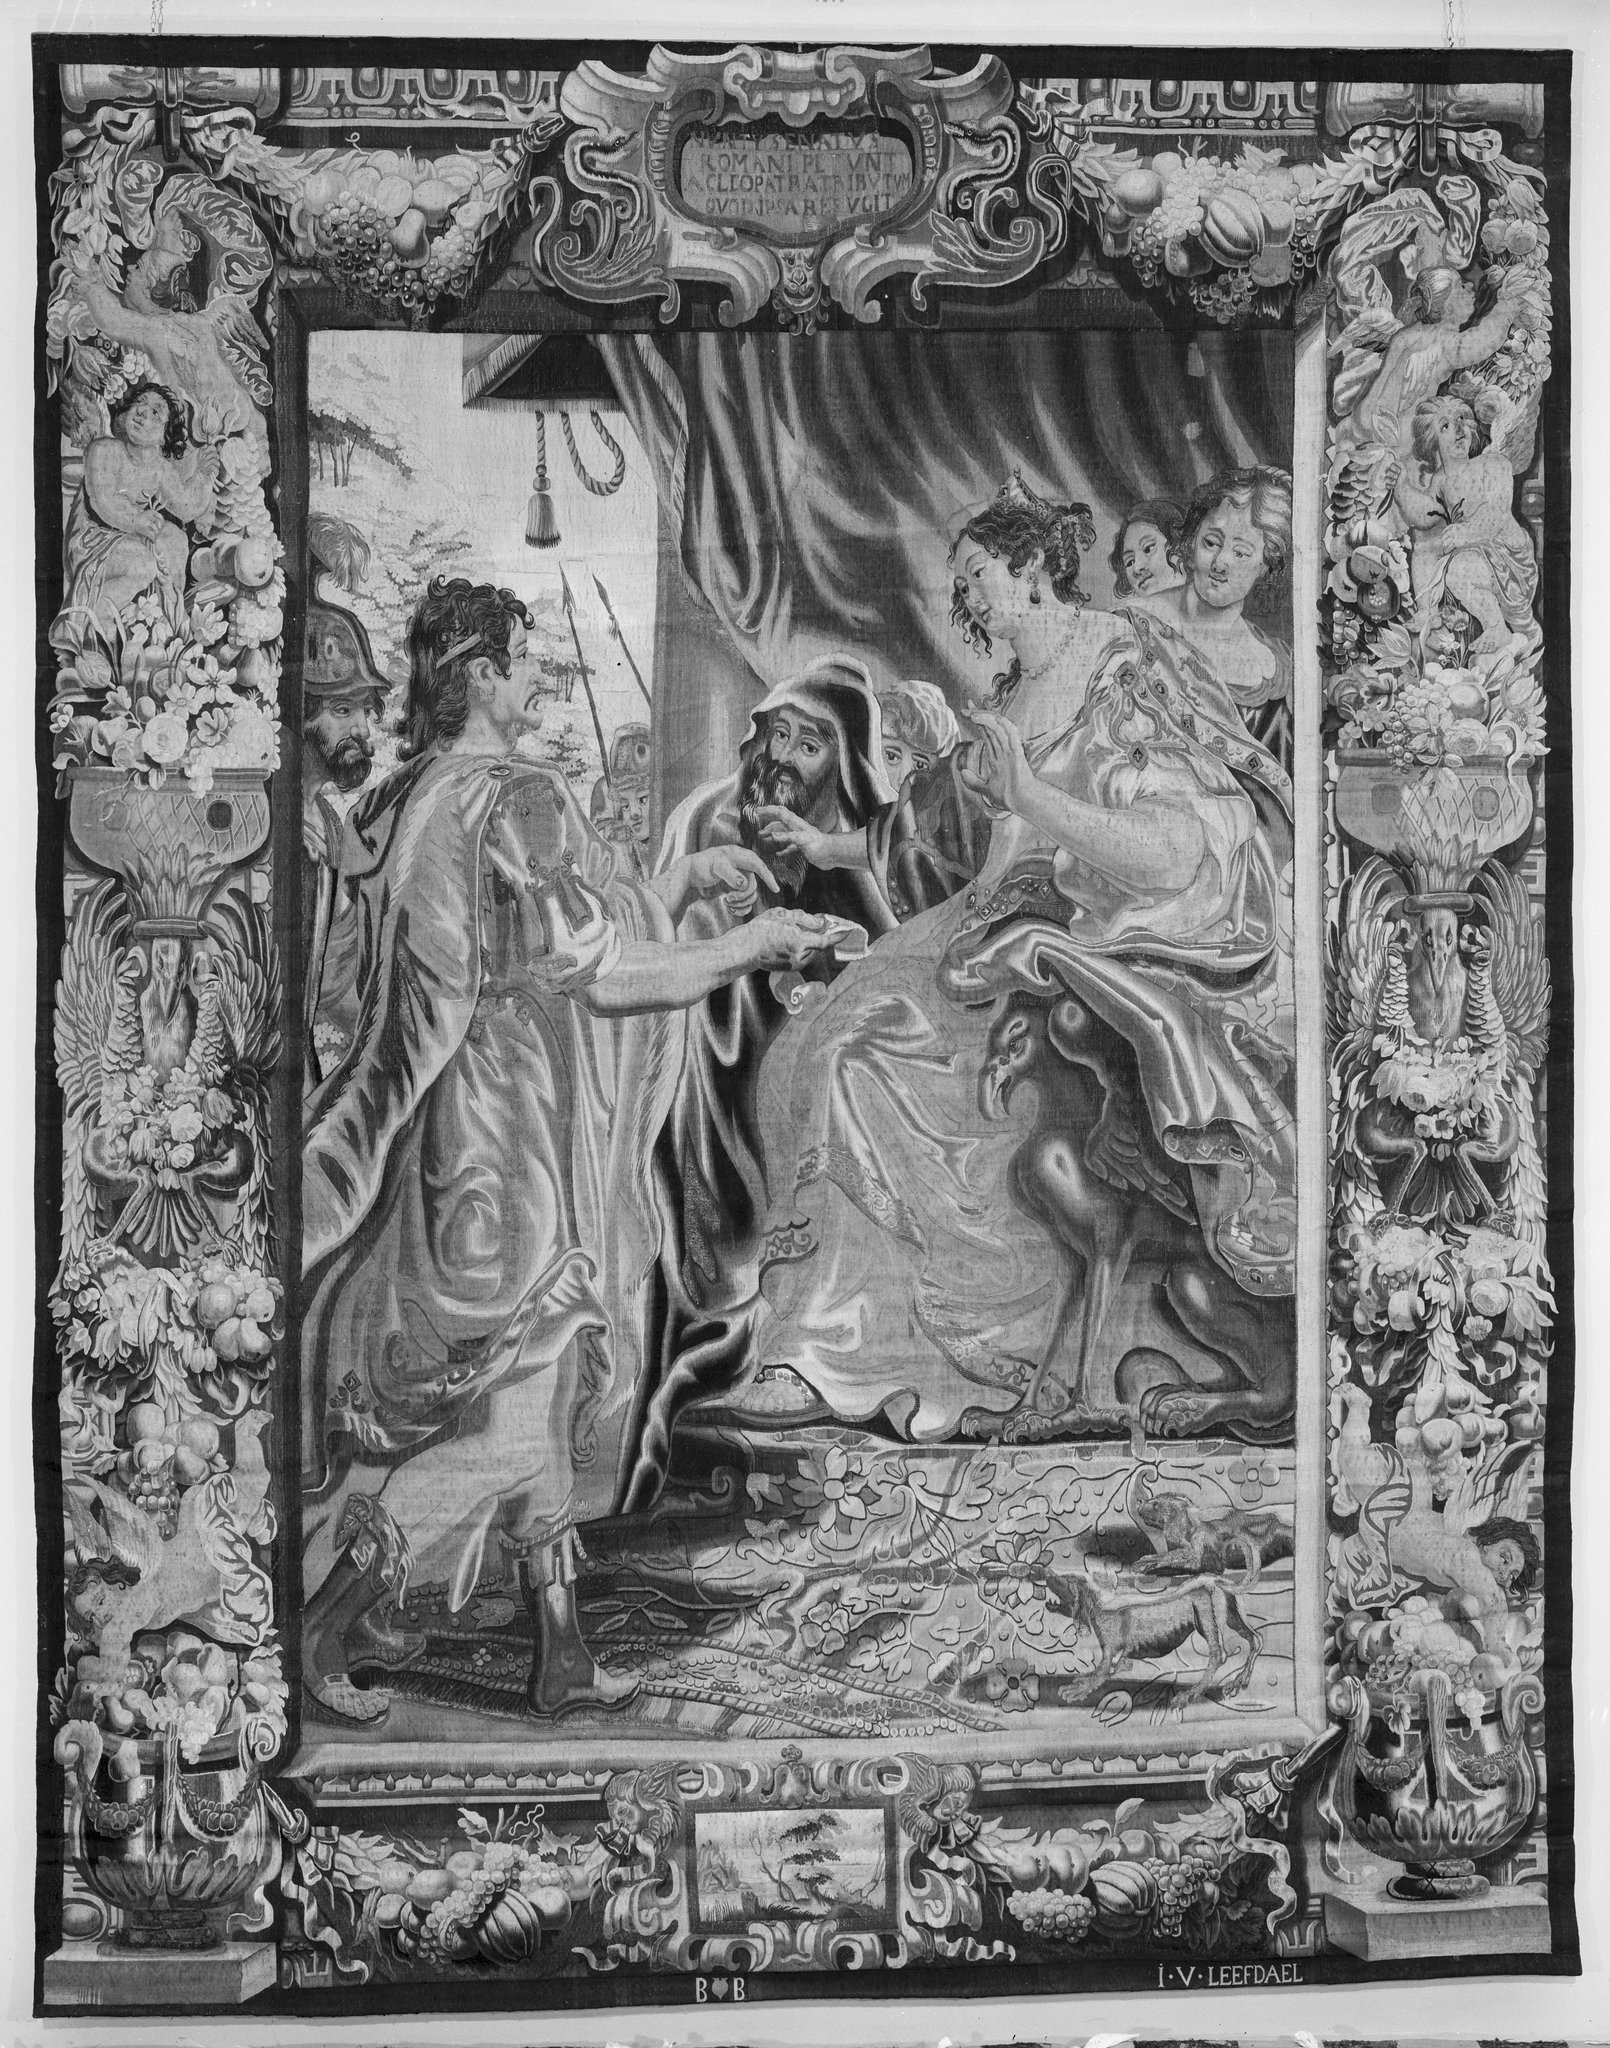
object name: tapestry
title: Cleopatra Asked to Pay Tribute to Rome from a set of The Story of Antony and Cleopatra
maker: justus van egmont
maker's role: designer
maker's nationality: flemish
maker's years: 1601-1674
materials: silk, silver, silver gilt, thread, wool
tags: fruit,cleopatra,men,dogs